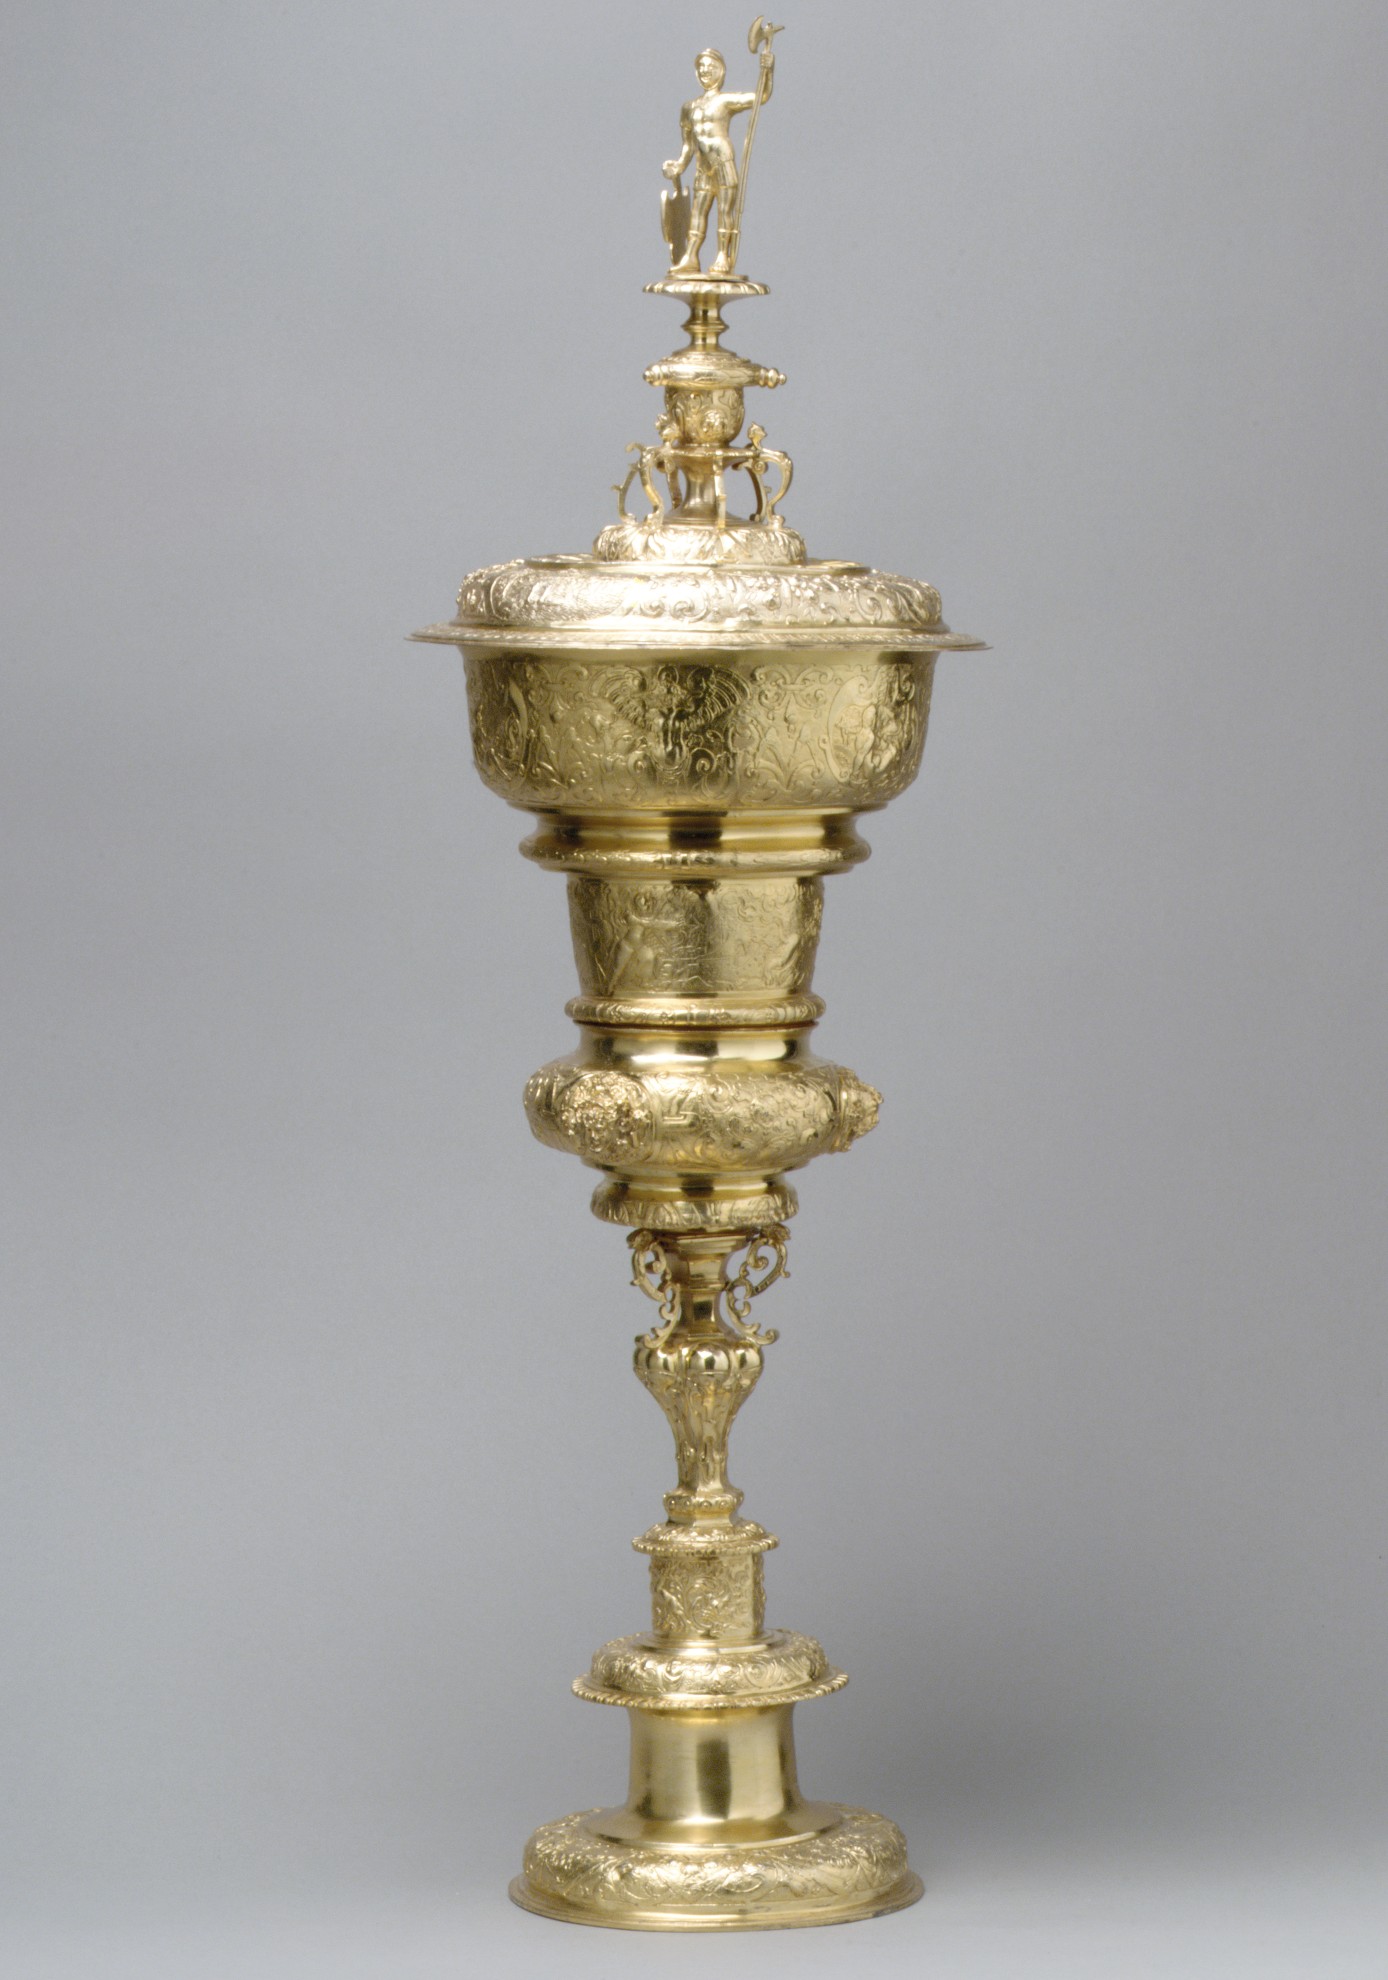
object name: standing cup with cover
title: Standing cup with cover (Hanap)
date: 1801-1900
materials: metal, silver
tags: men